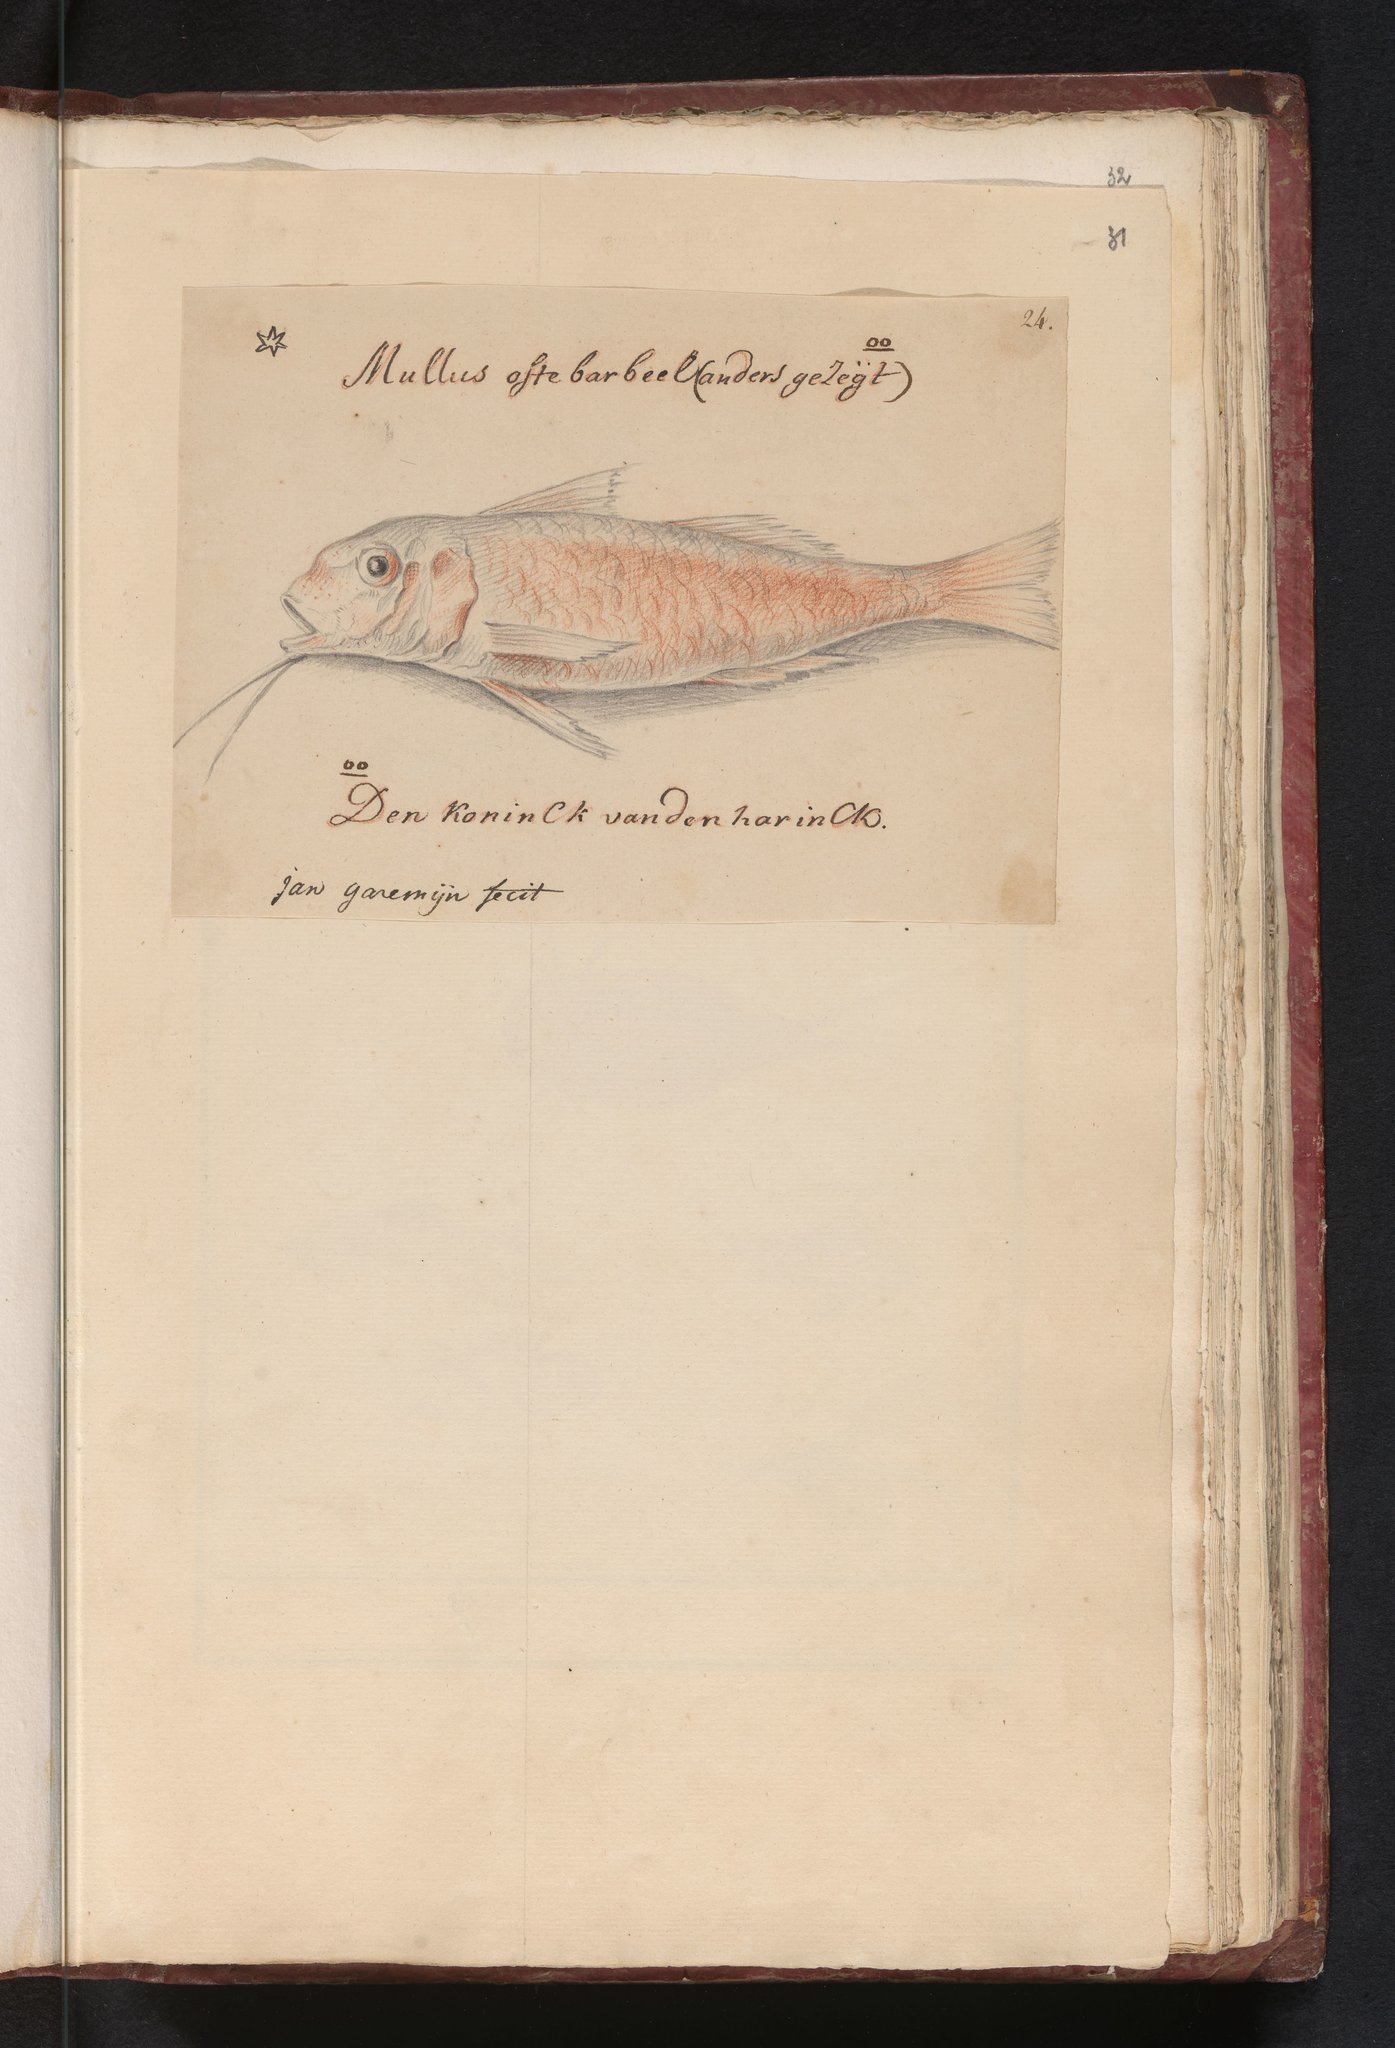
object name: drawing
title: Mullus ofte barbeel (anders gezegt) Den Koninck van den harinck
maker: jan anton garemyn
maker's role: draughtsman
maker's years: 1712-1799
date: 1790-1799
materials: chalk, paper, pencil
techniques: pen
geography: bruges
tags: bony fishes: mullet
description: Rode mul, ook wel de koning van de poon genoemd. Later aan het album toegevoegd blad. Genummerd rechtsboven: 24. Onderdeel van het zesde album met tekeningen van vissen, schelpen en insekten. Zesde van twaalf albums met tekeningen van dieren, vogels en planten bekend rond 1600, gemaakt in opdracht van keizer Rudolf II. Met toelichting in Nederlands, Latijn en Frans.